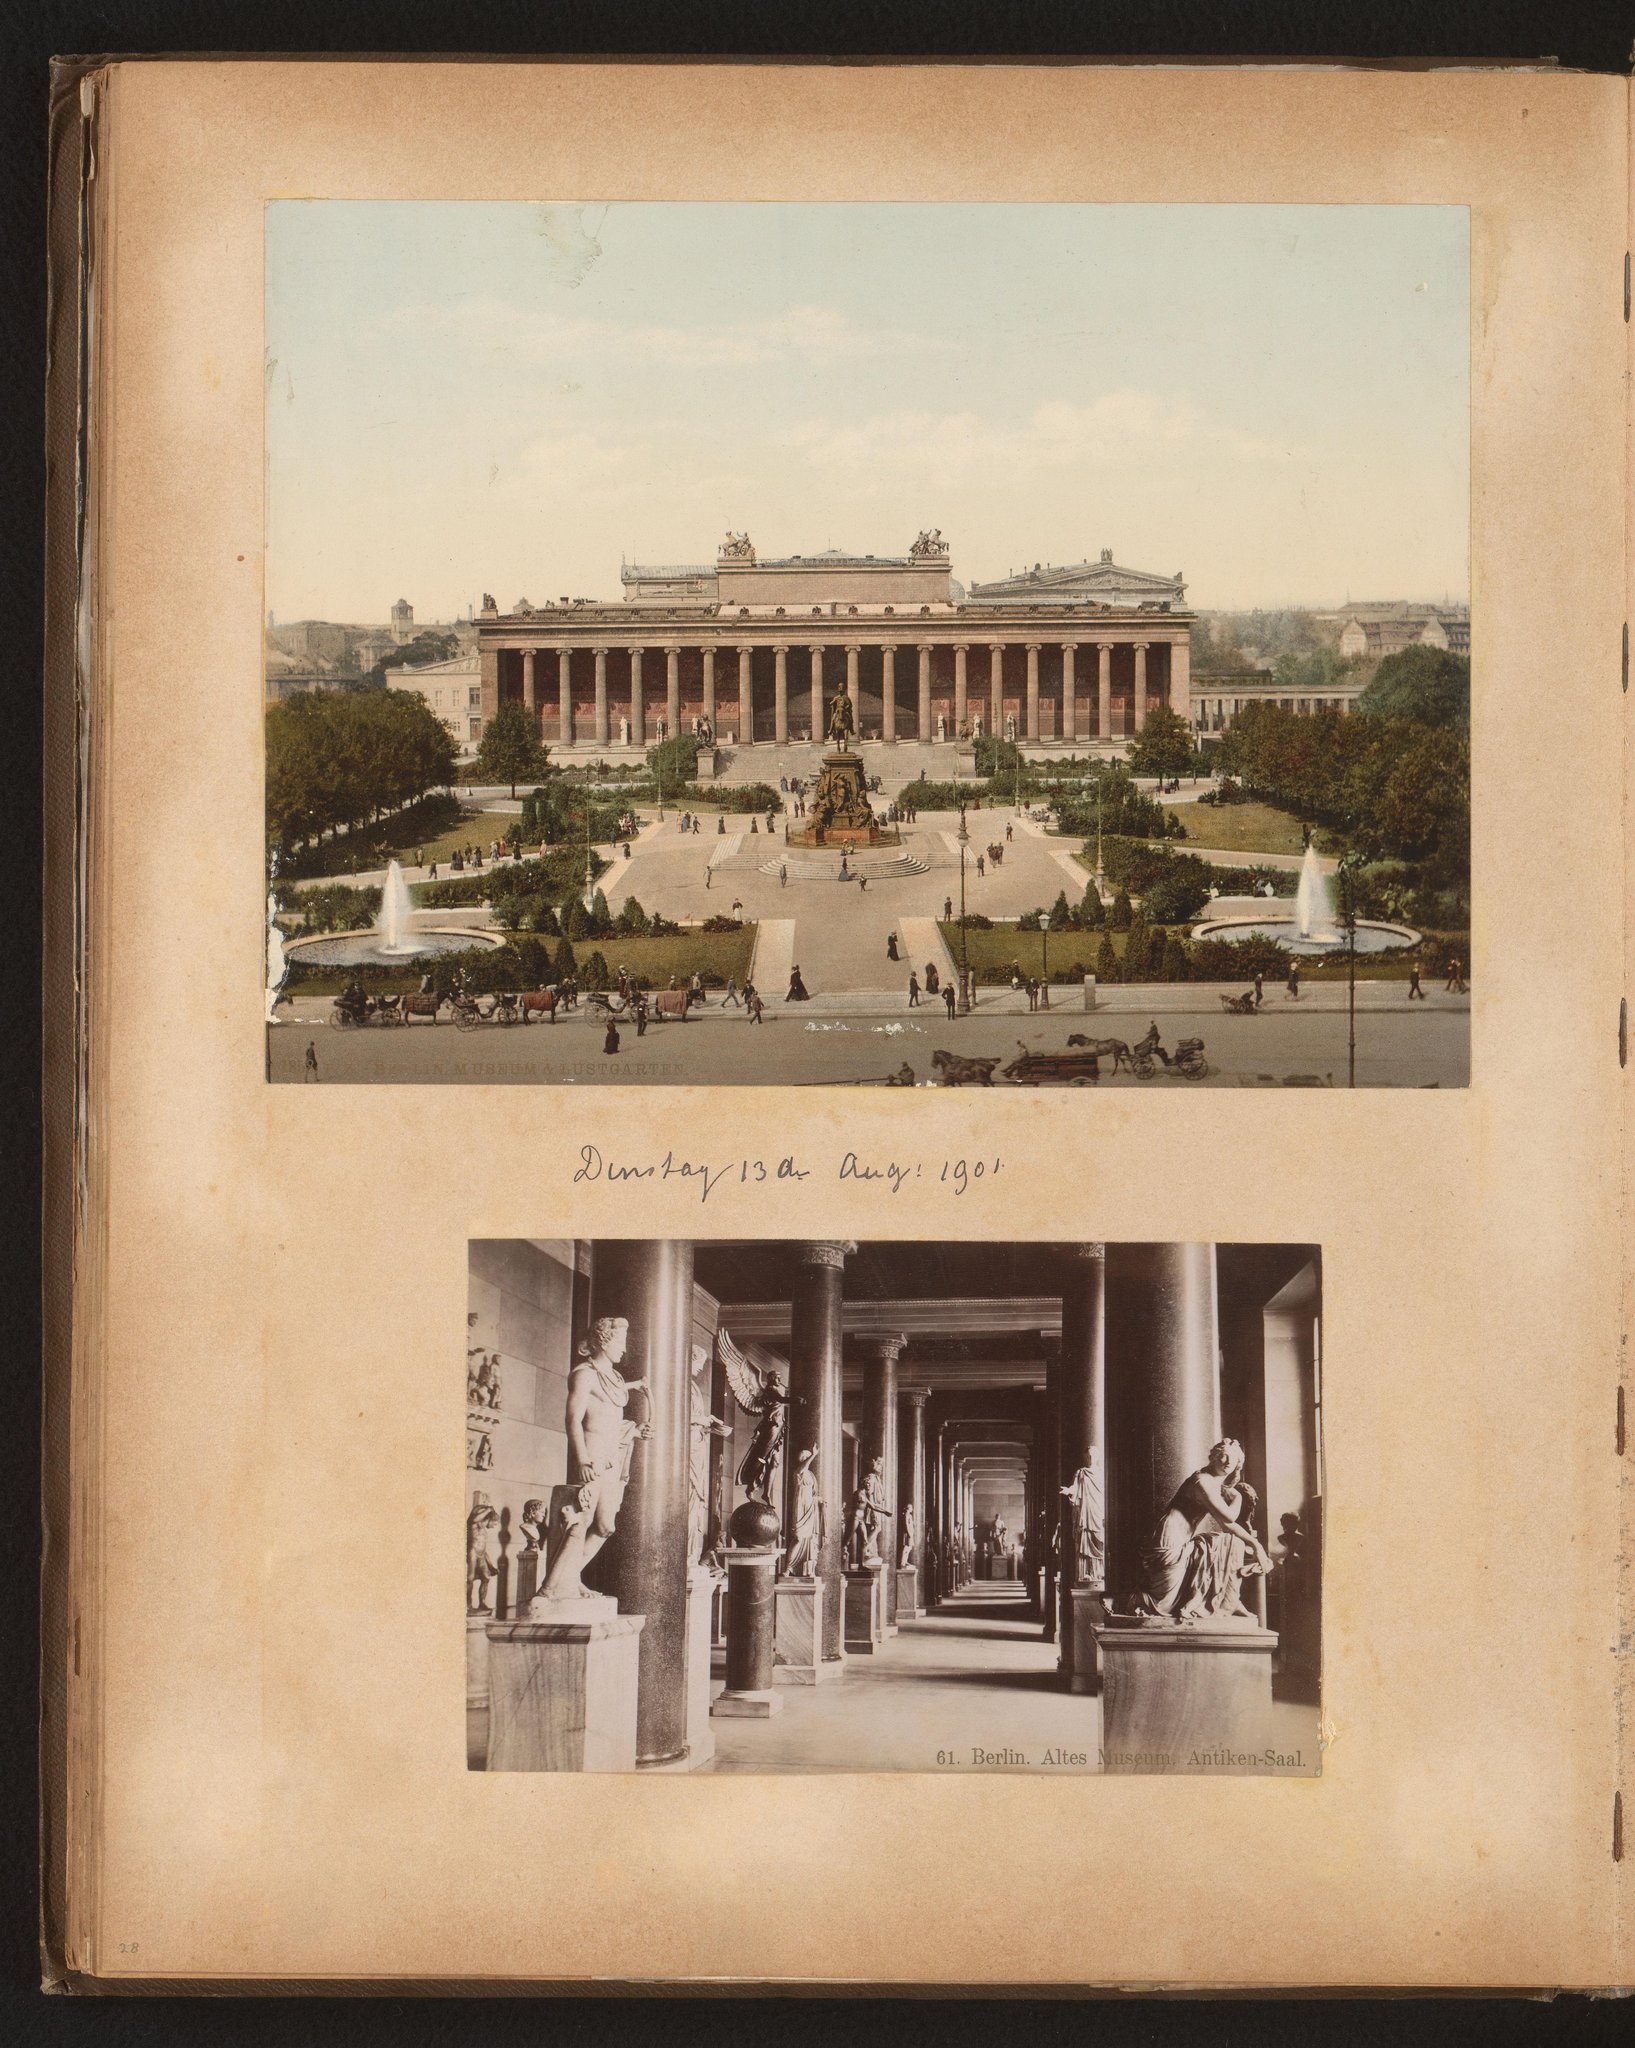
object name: photomechanical print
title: Exterieur en interieur van het Altes Museum, Berlijn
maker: Anonymous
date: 1896-1901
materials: paper, photographic process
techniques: albumen print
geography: berlin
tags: permanent exhibition, museum, public gardens, park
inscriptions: title: ‘61. Berlin. Altes Museum. Antiken-Saal.’, inscription: ‘Dinsdag 13den Aug: 1901’, title: ‘1858. P.Z.- Berlin. Museum & Lustgarten’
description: Deze fotomechanische afdruk en foto maken deel uit van een album.